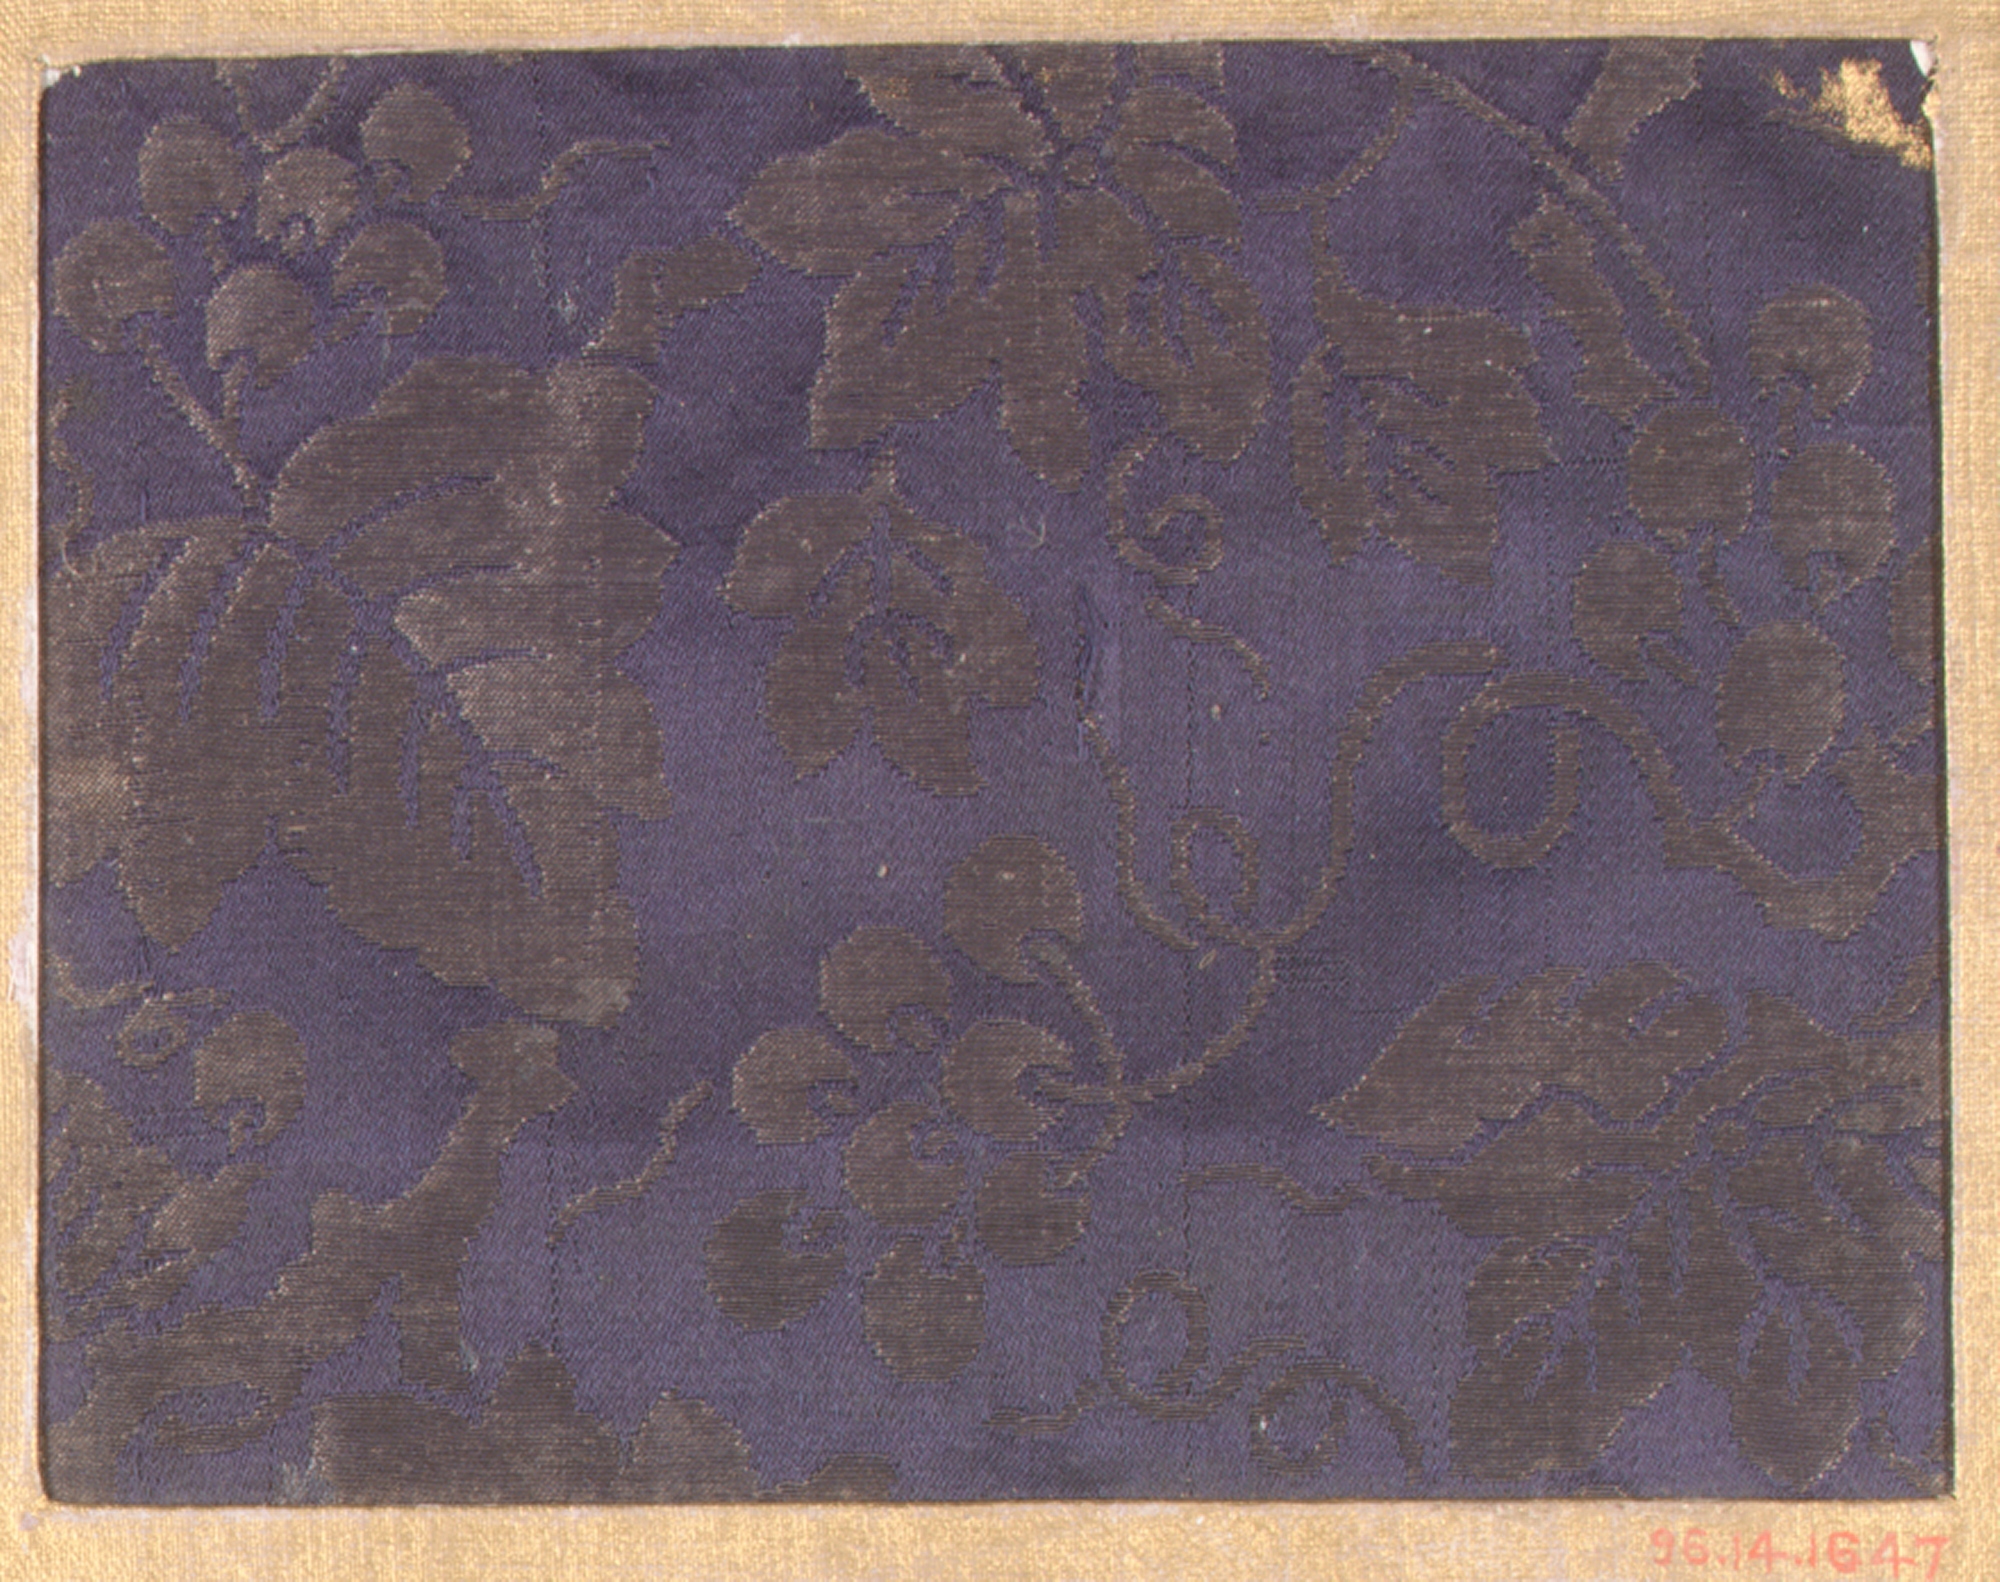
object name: piece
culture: japanese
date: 1701-1900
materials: silk